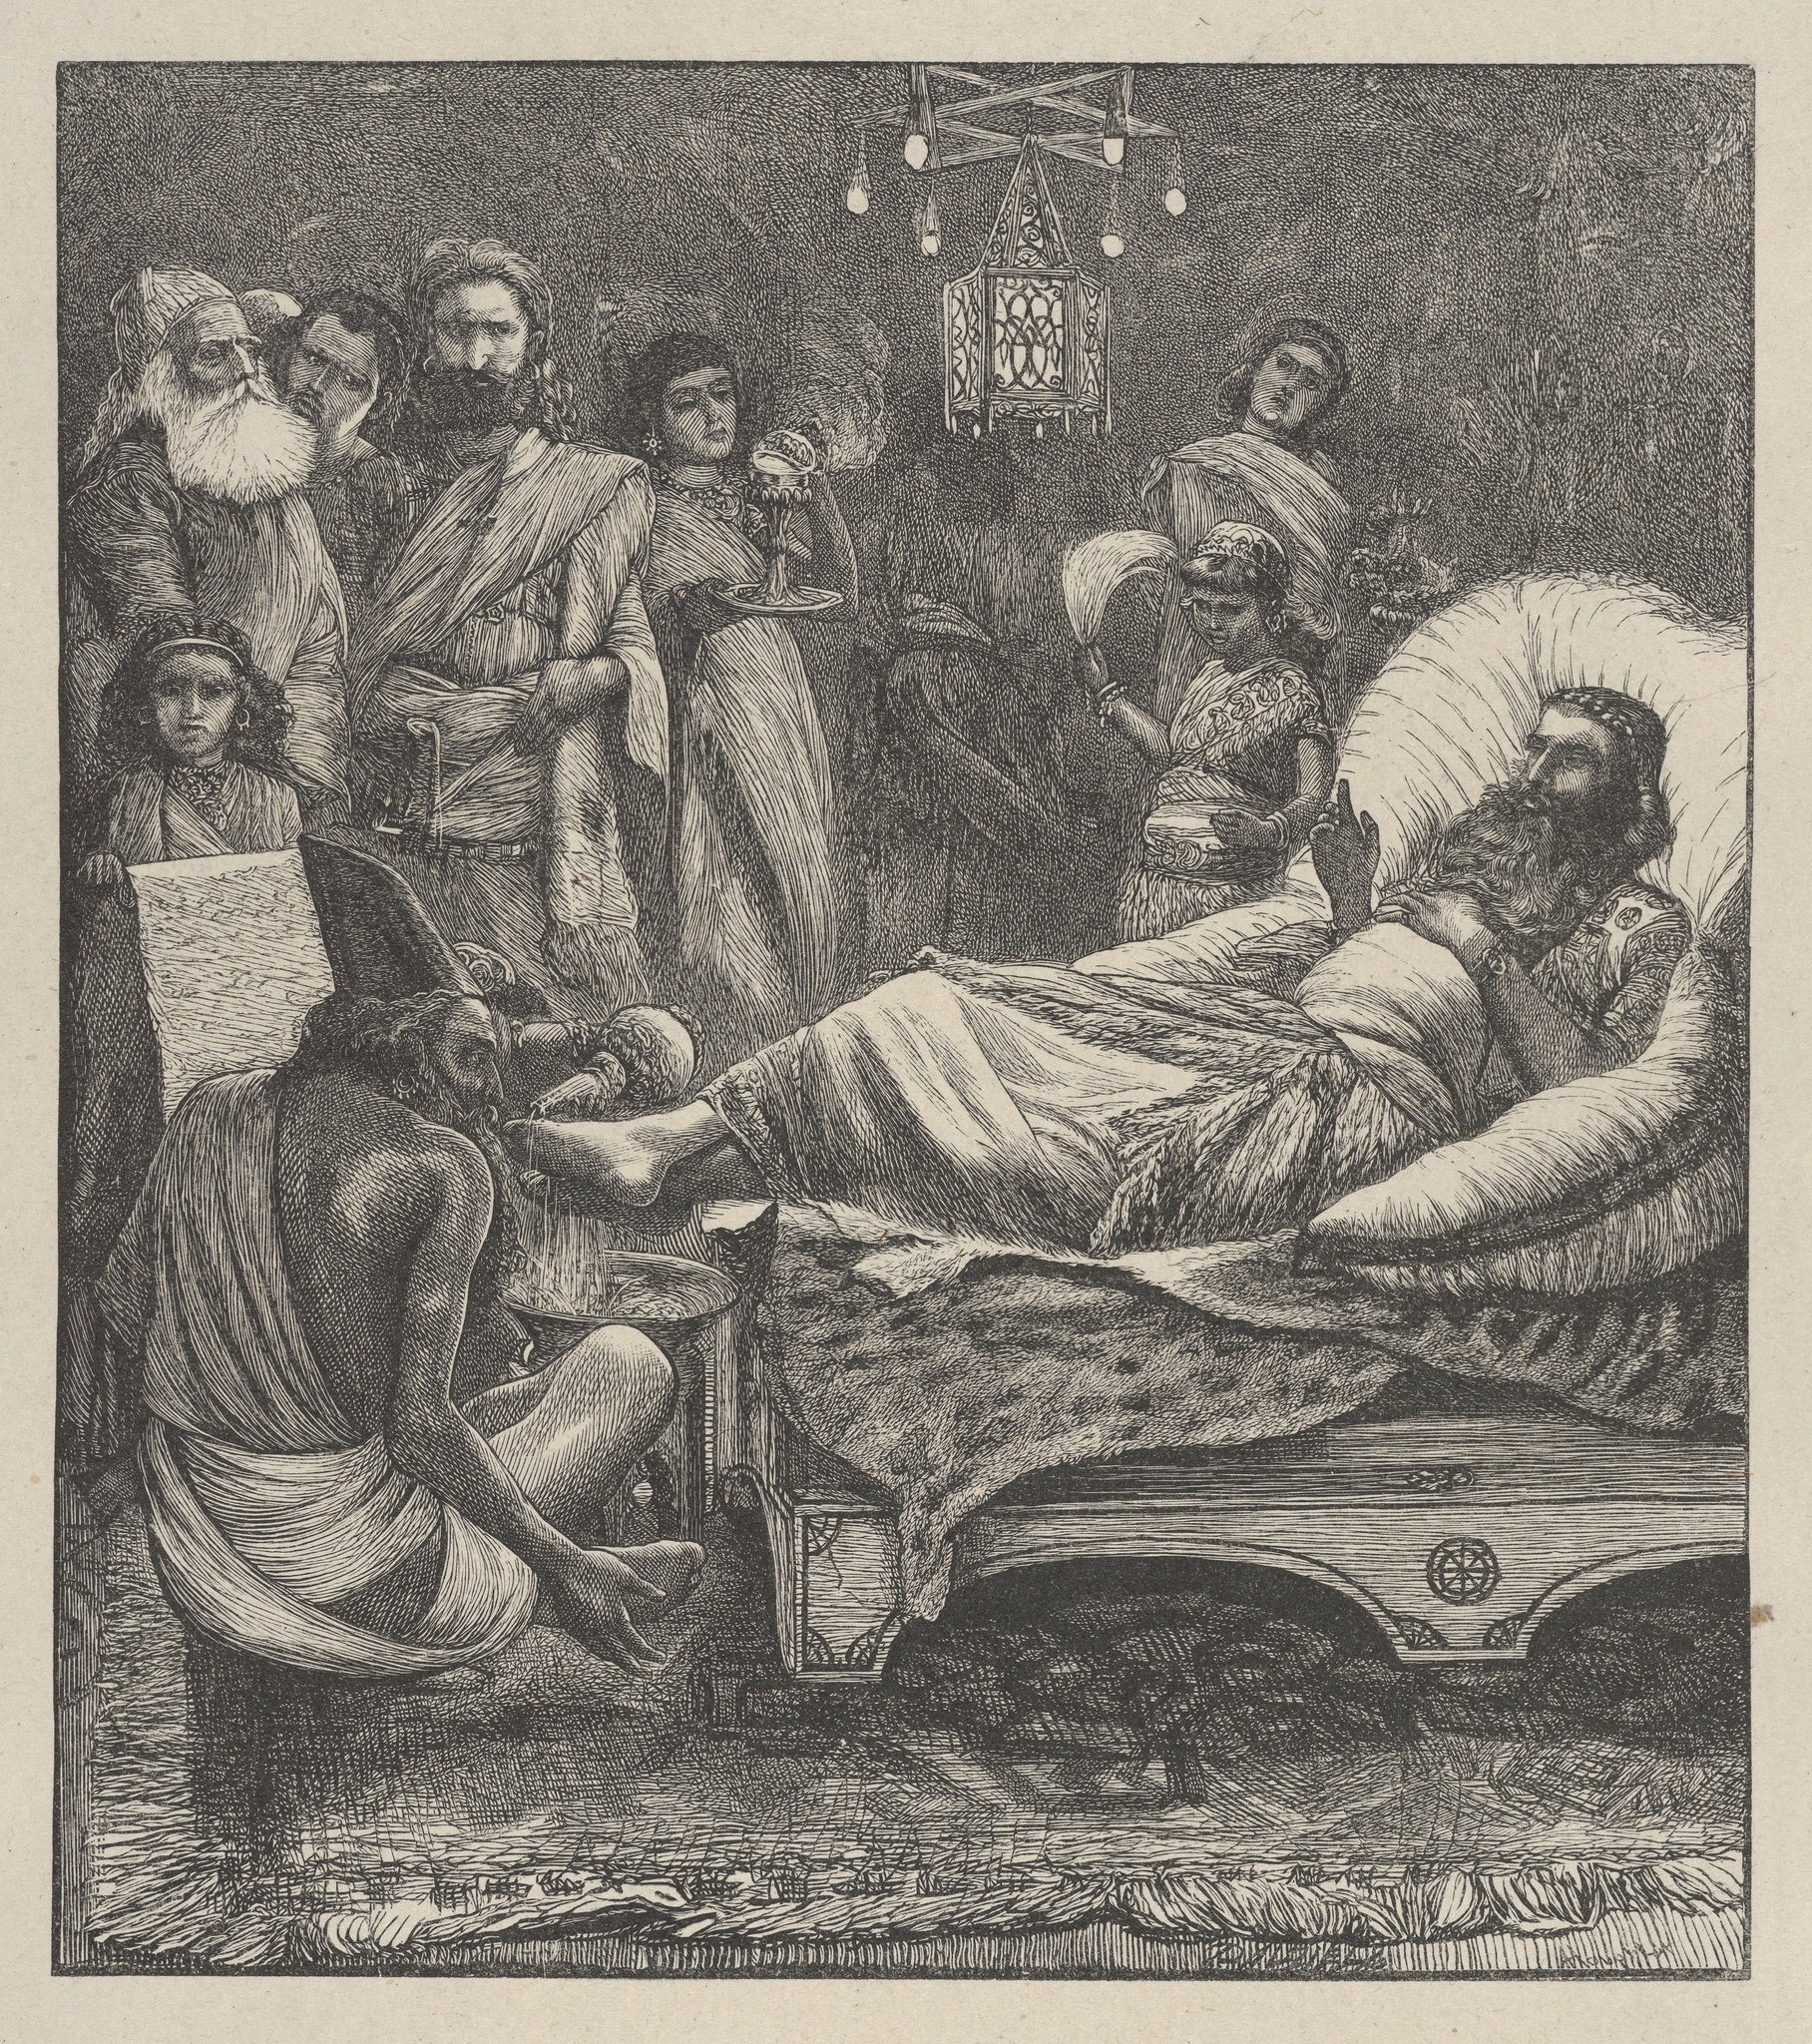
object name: print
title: The Chronicles Being Read to the King, from "Dalziels' Bible Gallery"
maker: arthur boyd houghton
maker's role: artist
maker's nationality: british, born india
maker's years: 1836-1875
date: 1865-1881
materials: paper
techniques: engraving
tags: girls,men,women